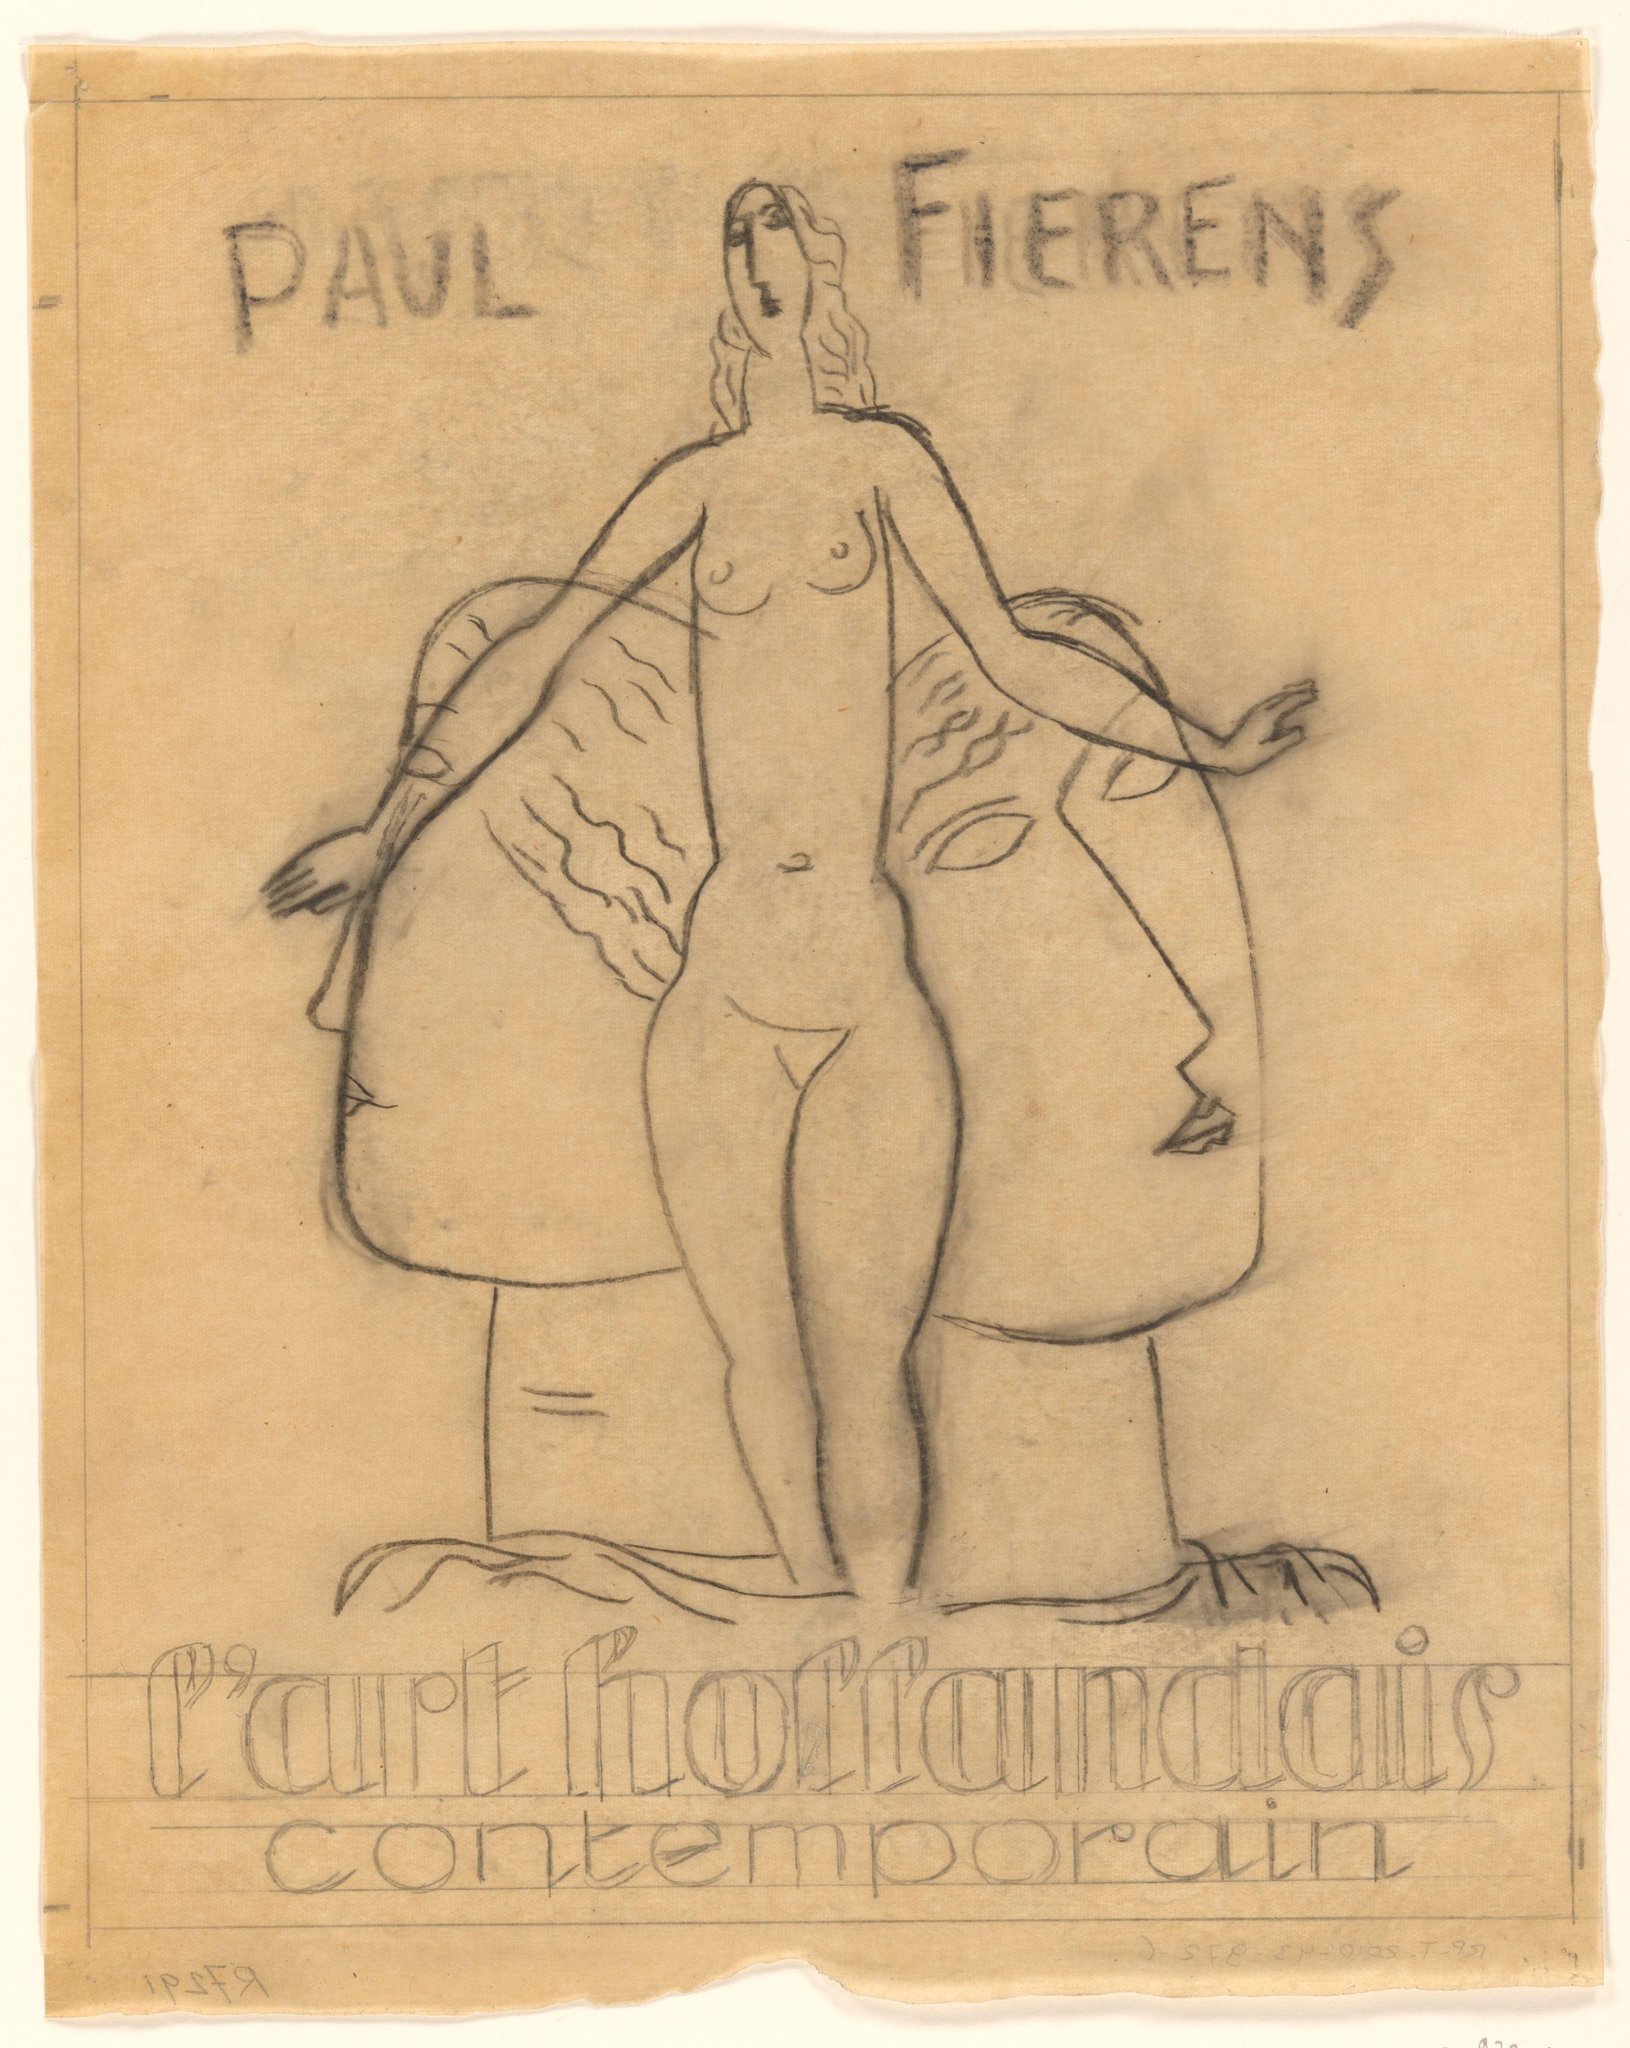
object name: study for binding design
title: Ontwerp boekomslag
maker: leo gestel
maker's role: draughtsman, print maker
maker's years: 1881-1941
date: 1933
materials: chalk, pencil, paper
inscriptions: inscription: ‘L´art hollandais/ contemporain’, inscription: ‘PAUL FIERENS’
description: Vrouwelijk naakt tussen twee gezichten, met tekst; ontwerp voor boekomslag Paul Fierens 'L'Art Hollandais contemporain'.